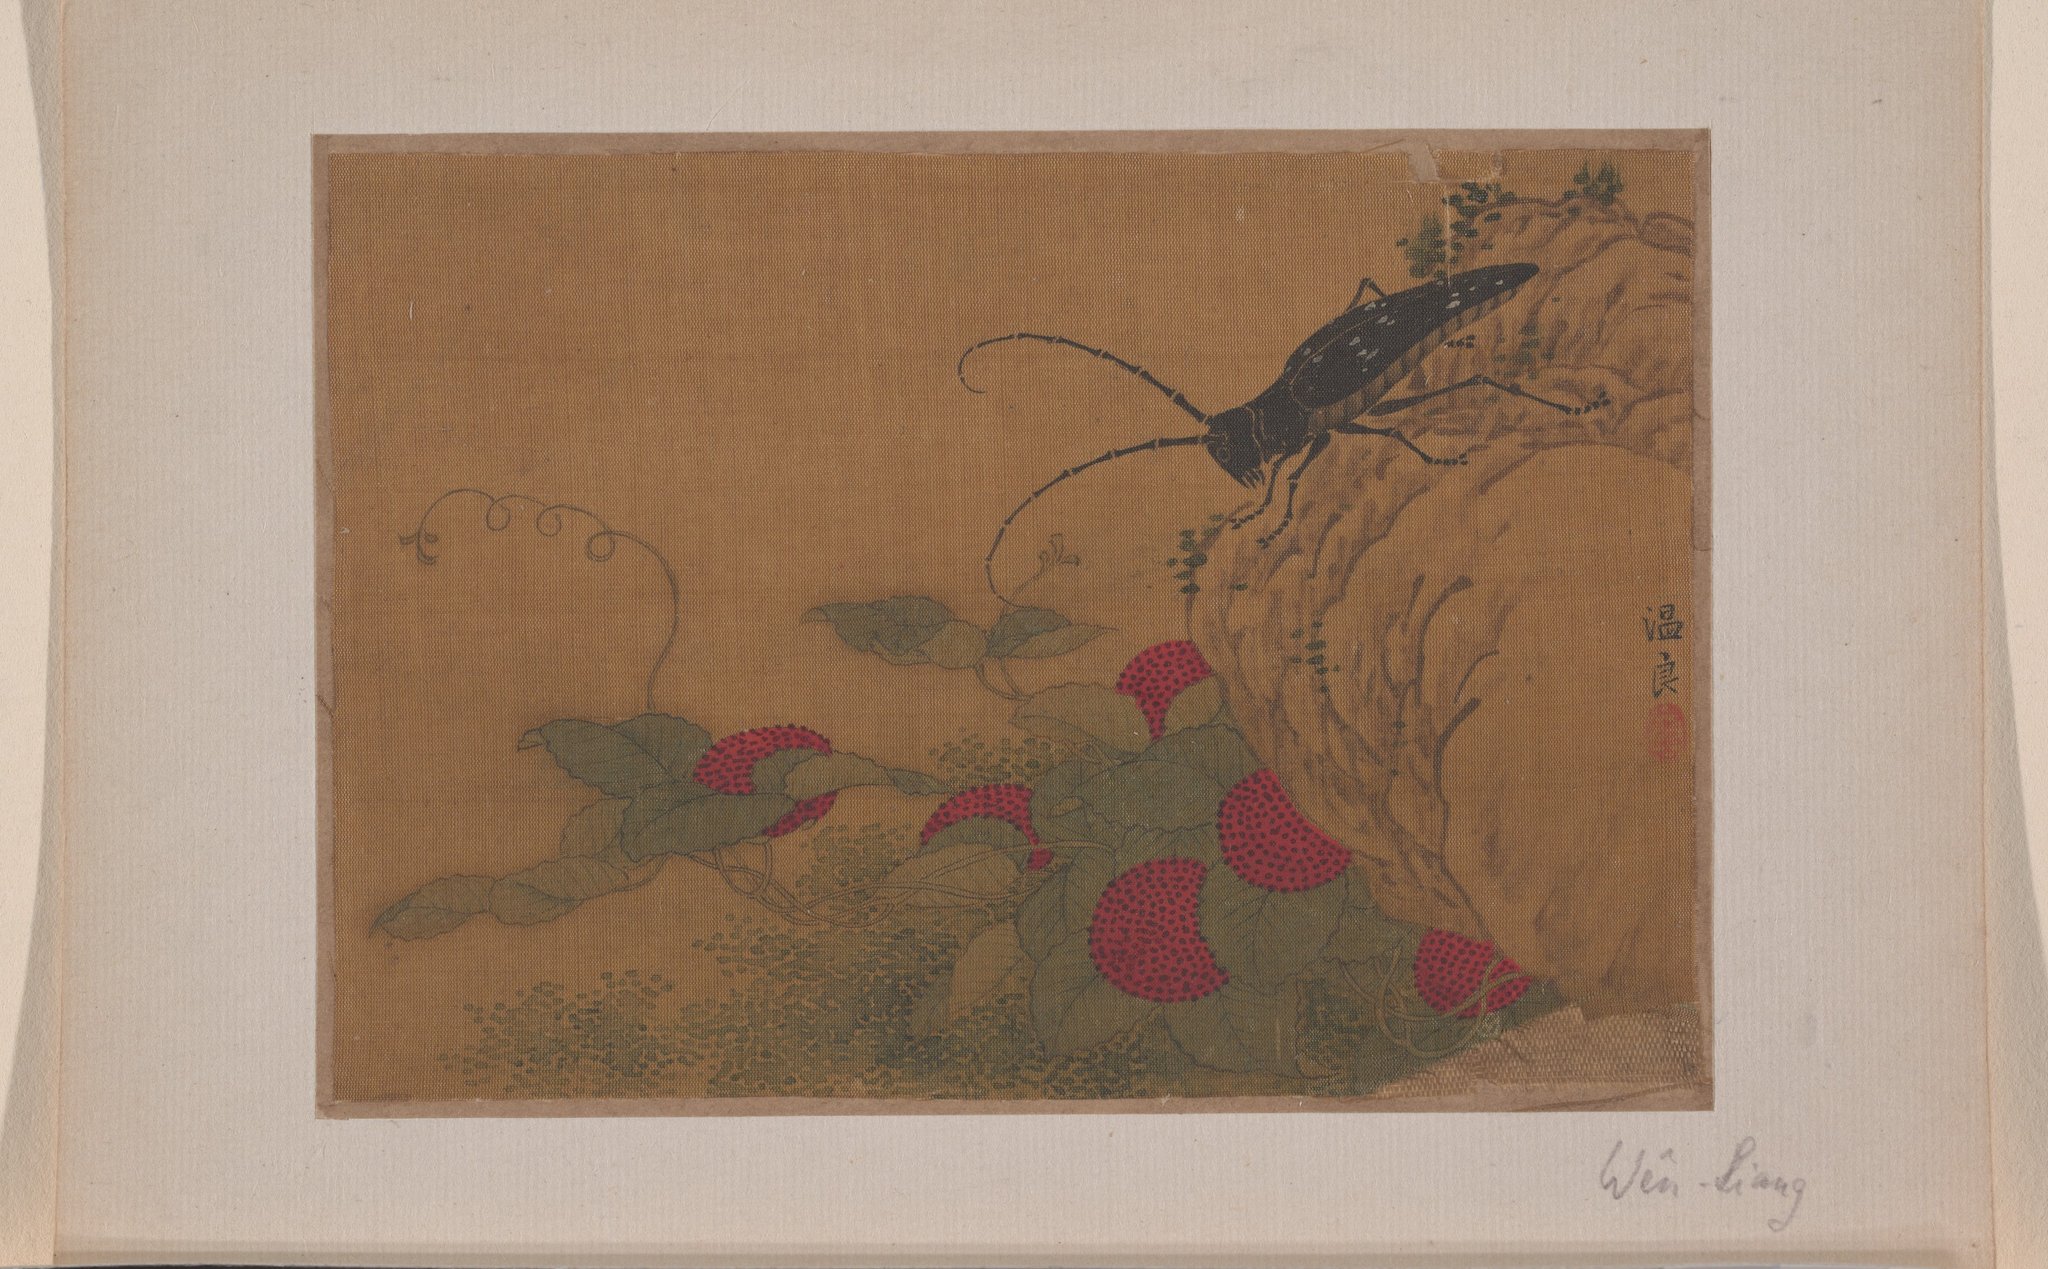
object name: album leaf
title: Grasshopper on Rock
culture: chinese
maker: wen liang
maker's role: artist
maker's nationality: chinese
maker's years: 1400-1499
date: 1401-1500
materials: ink, silk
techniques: painting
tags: strawberries,insects